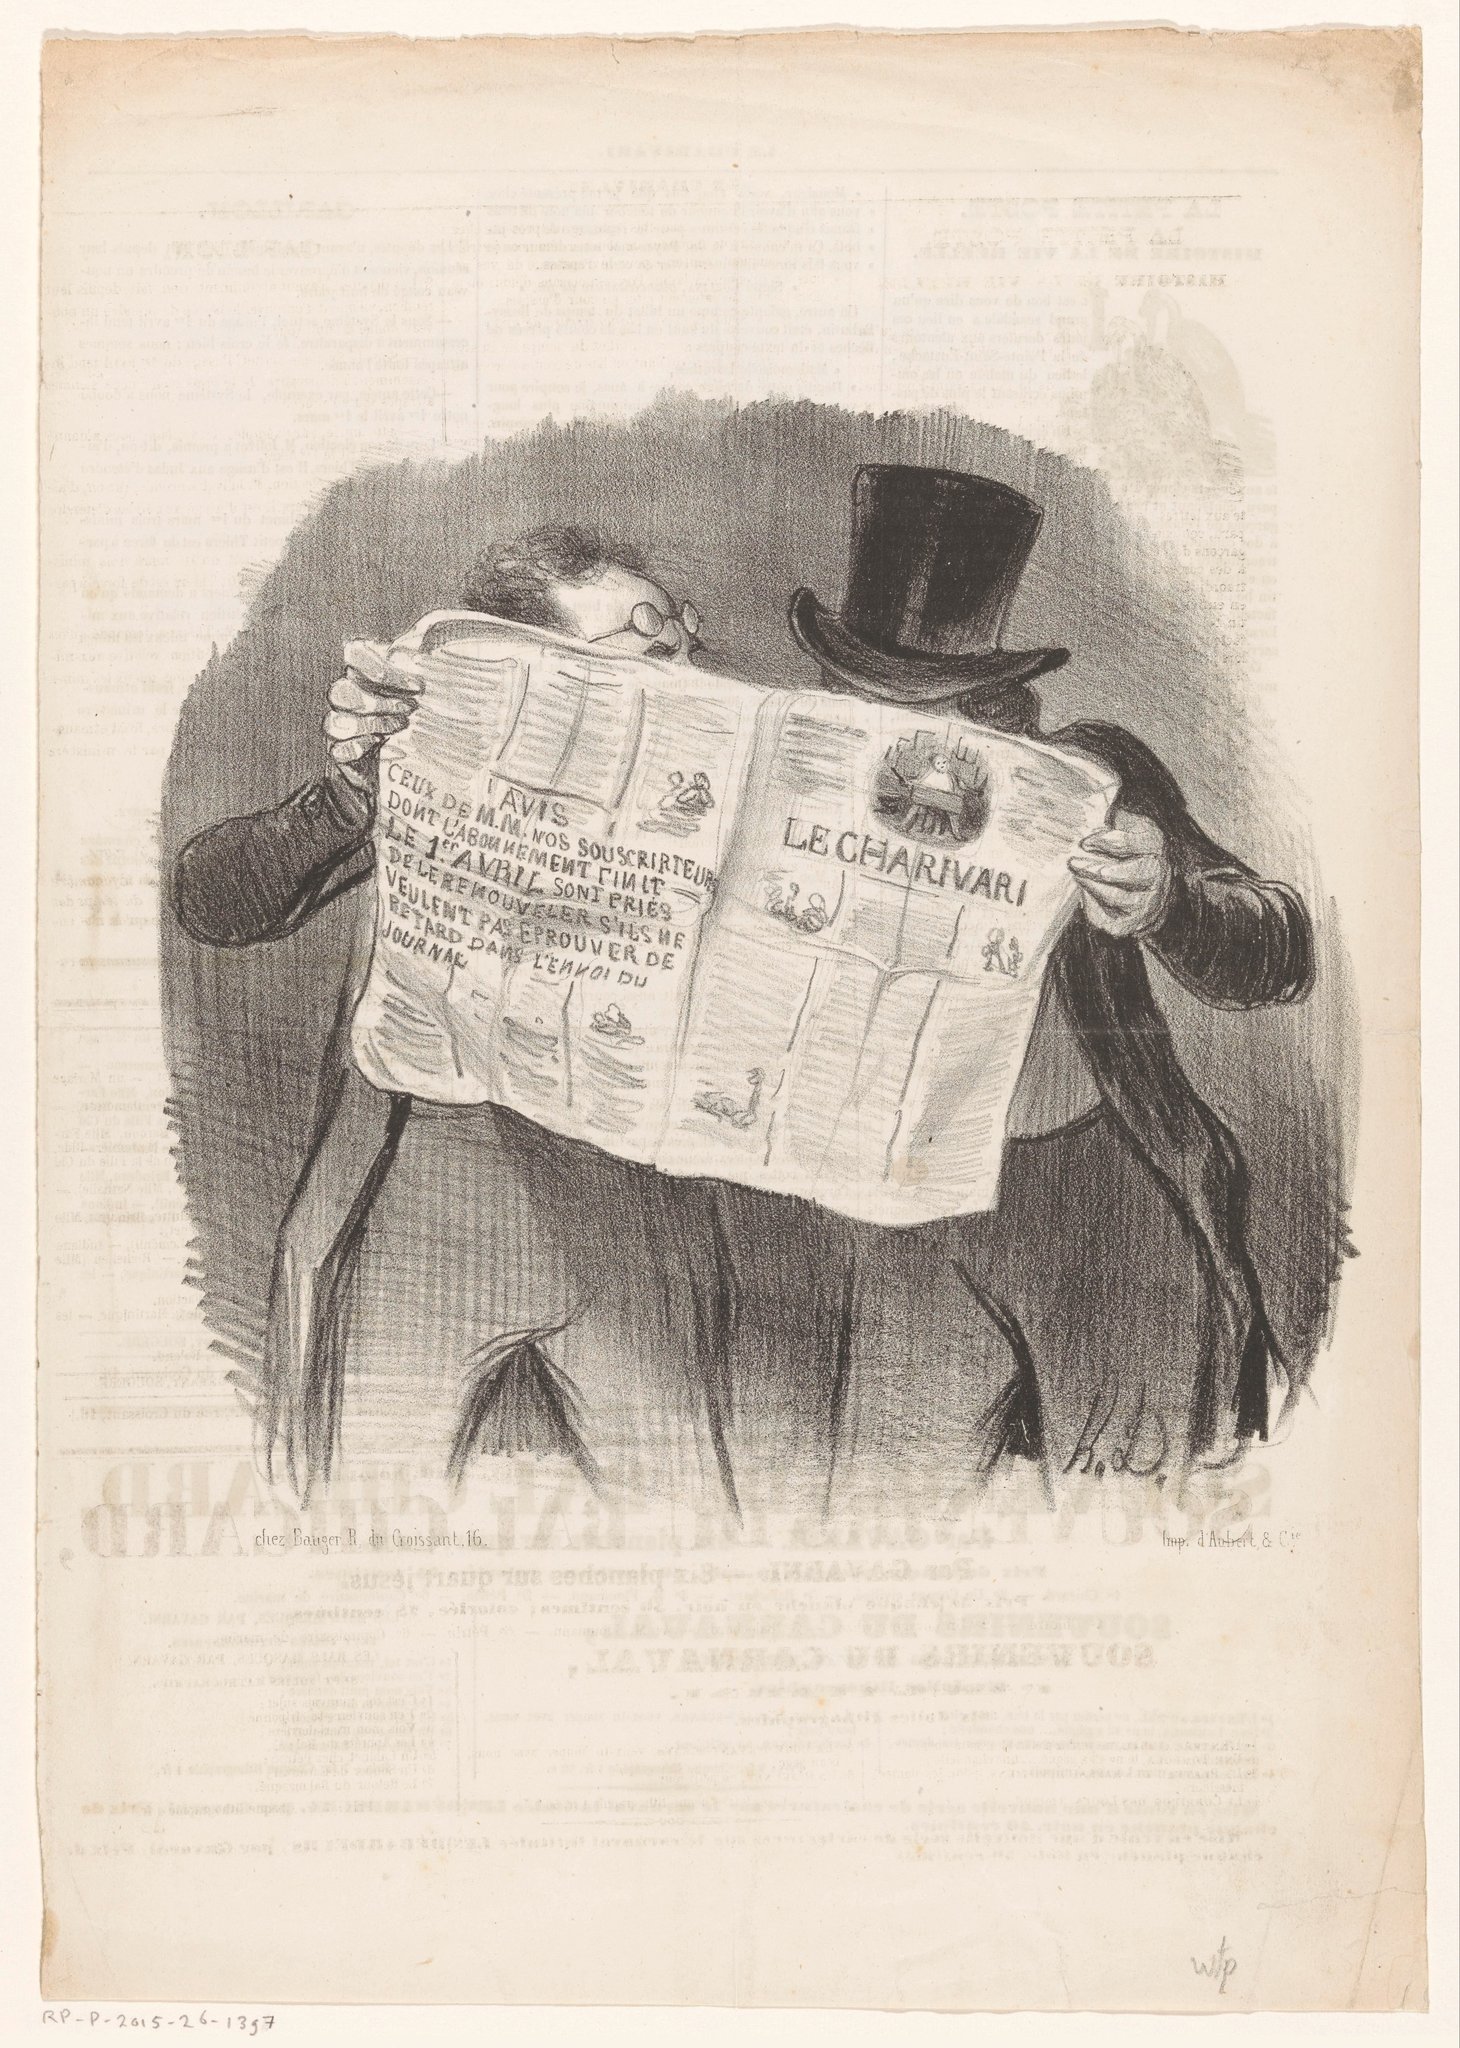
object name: print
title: Twee mannen lezen 'Le Charivari'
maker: honoré daumier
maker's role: draughtsman, painter, print maker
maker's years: 1808-1879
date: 1804-1840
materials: paper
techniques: lithograph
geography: paris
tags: reading, newspaper, news-sheet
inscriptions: collector's mark: Lugt 4779, collector's mark: Lugt 2228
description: Prent afkomstig uit: Le Charivari, 1 april 1840.